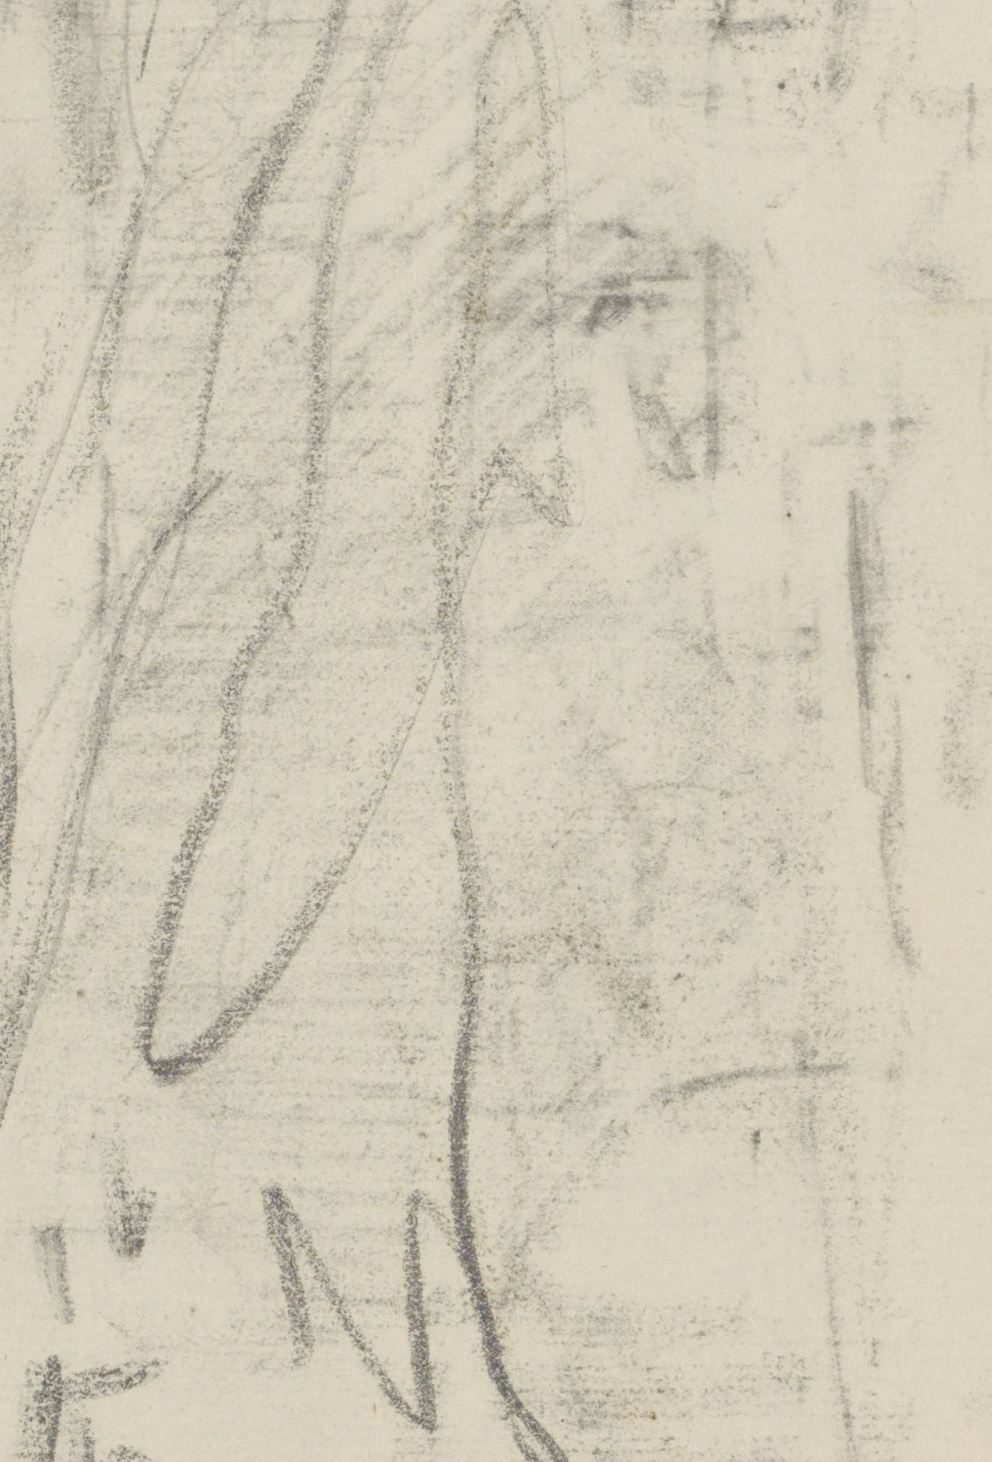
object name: sketchbook leaf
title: Studie, mogelijk van een wolkenlucht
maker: george hendrik breitner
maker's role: draughtsman, painter, print maker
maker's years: 1857-1923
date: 1887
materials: paper, pencil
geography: amsterdam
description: Pagina 18 uit een schetsboek met 12 bladen.